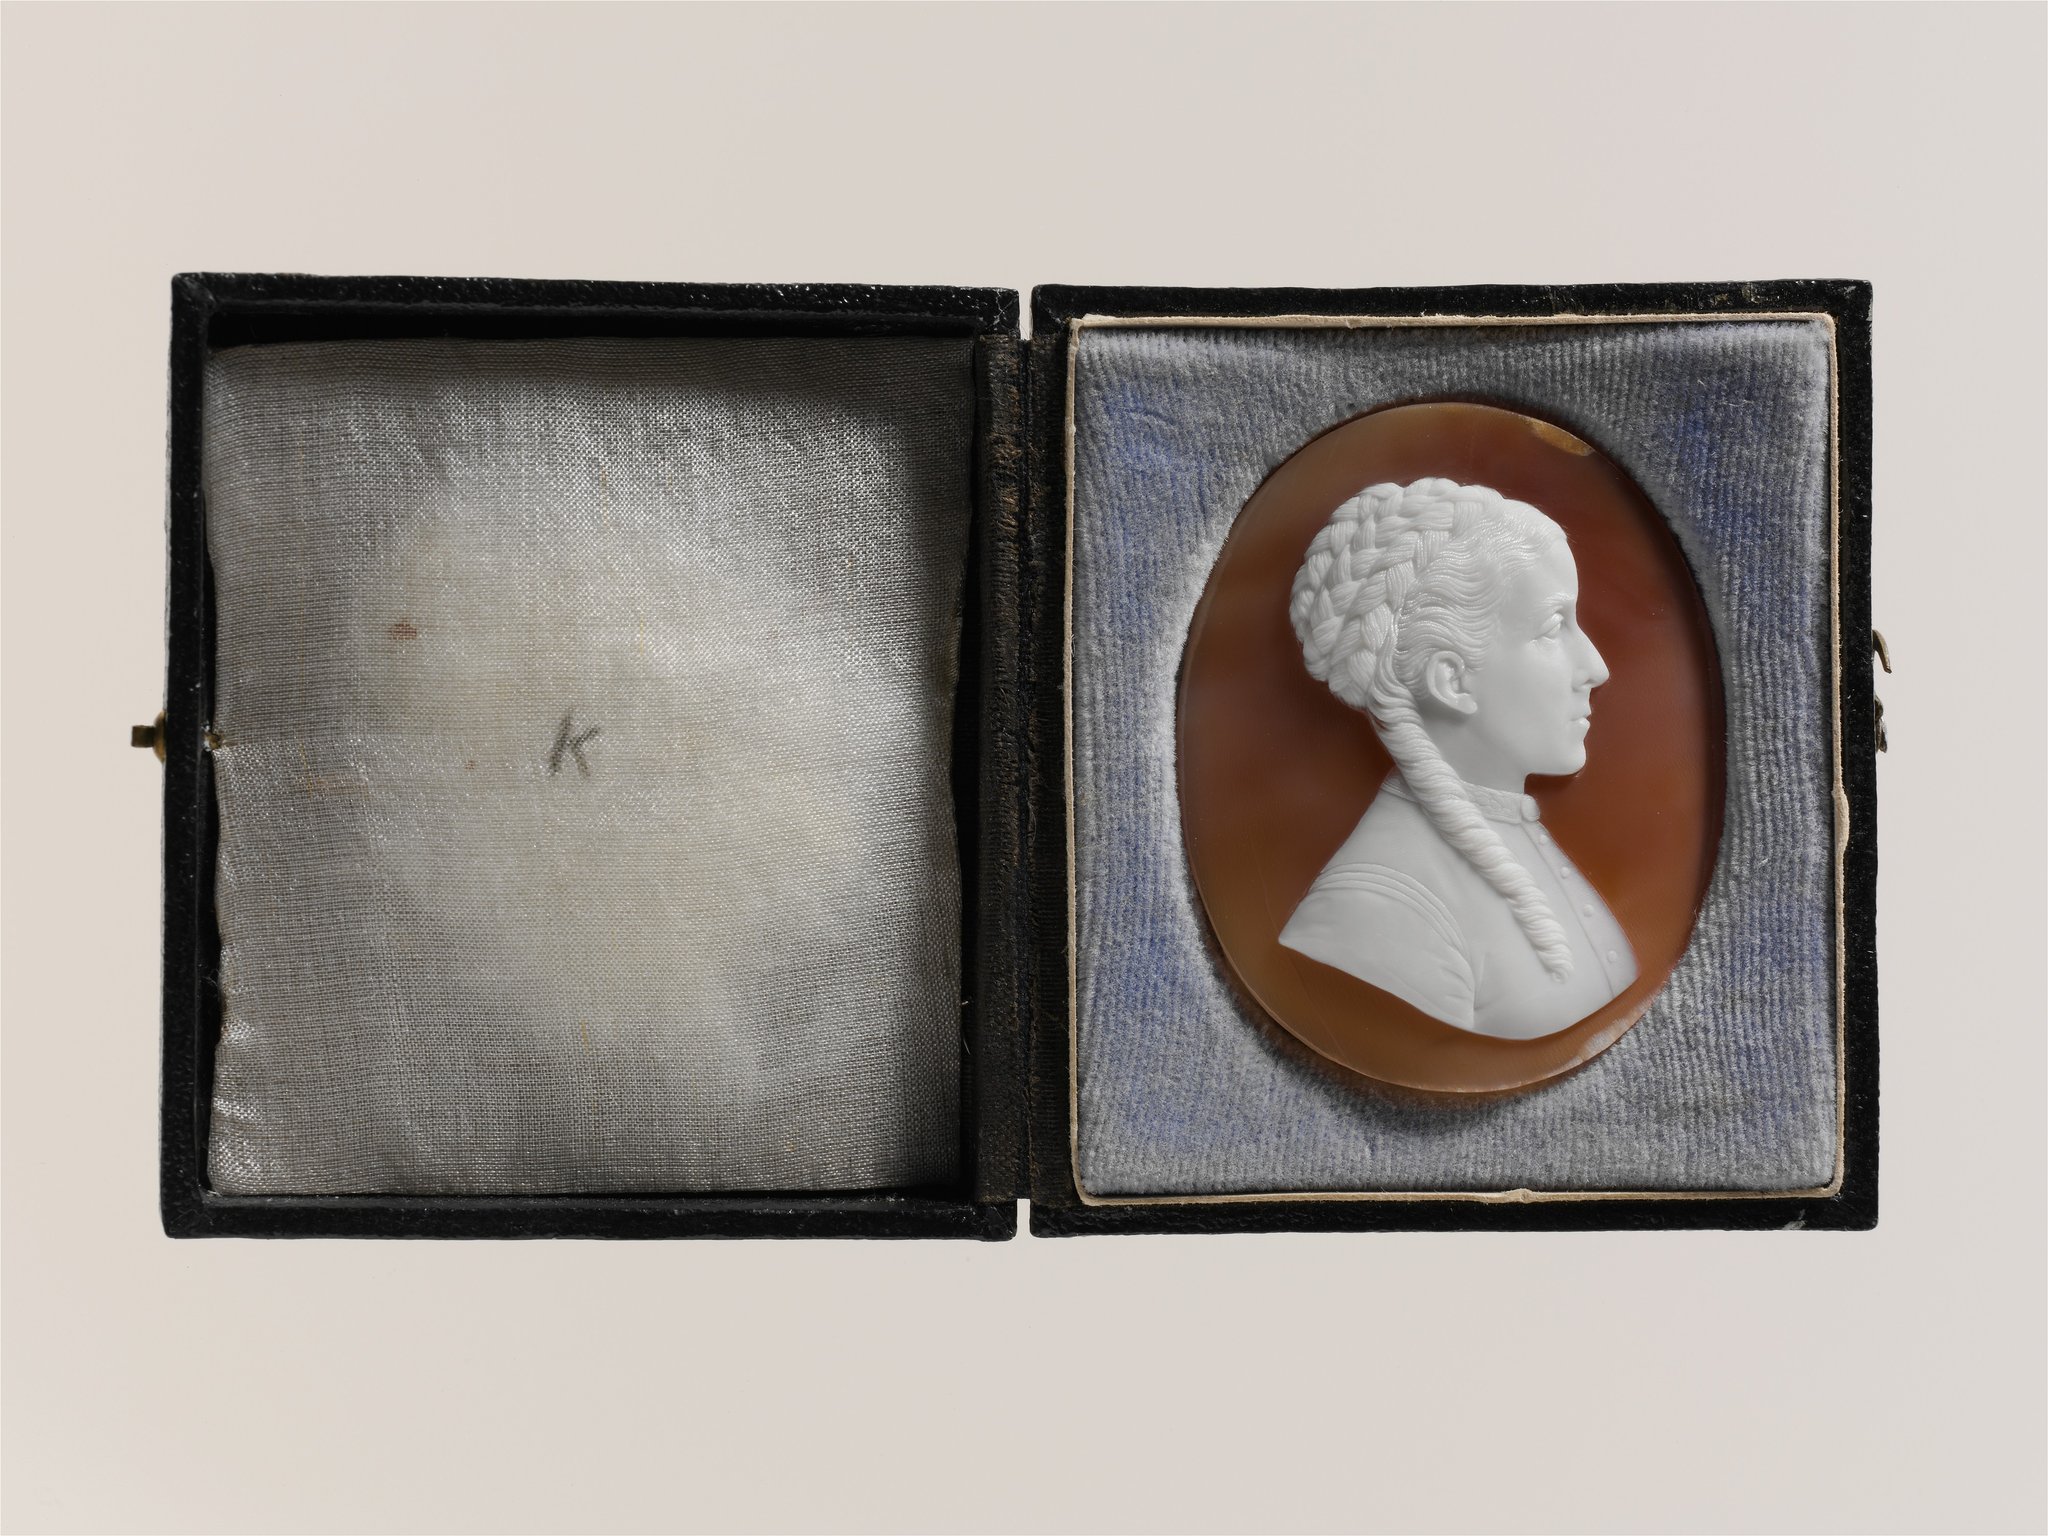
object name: cameo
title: Hannah Rohr Tuffs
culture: american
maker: augustus saint-gaudens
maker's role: artist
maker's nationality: american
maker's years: 1848-1907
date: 1872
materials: shell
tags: portraits,profiles,women